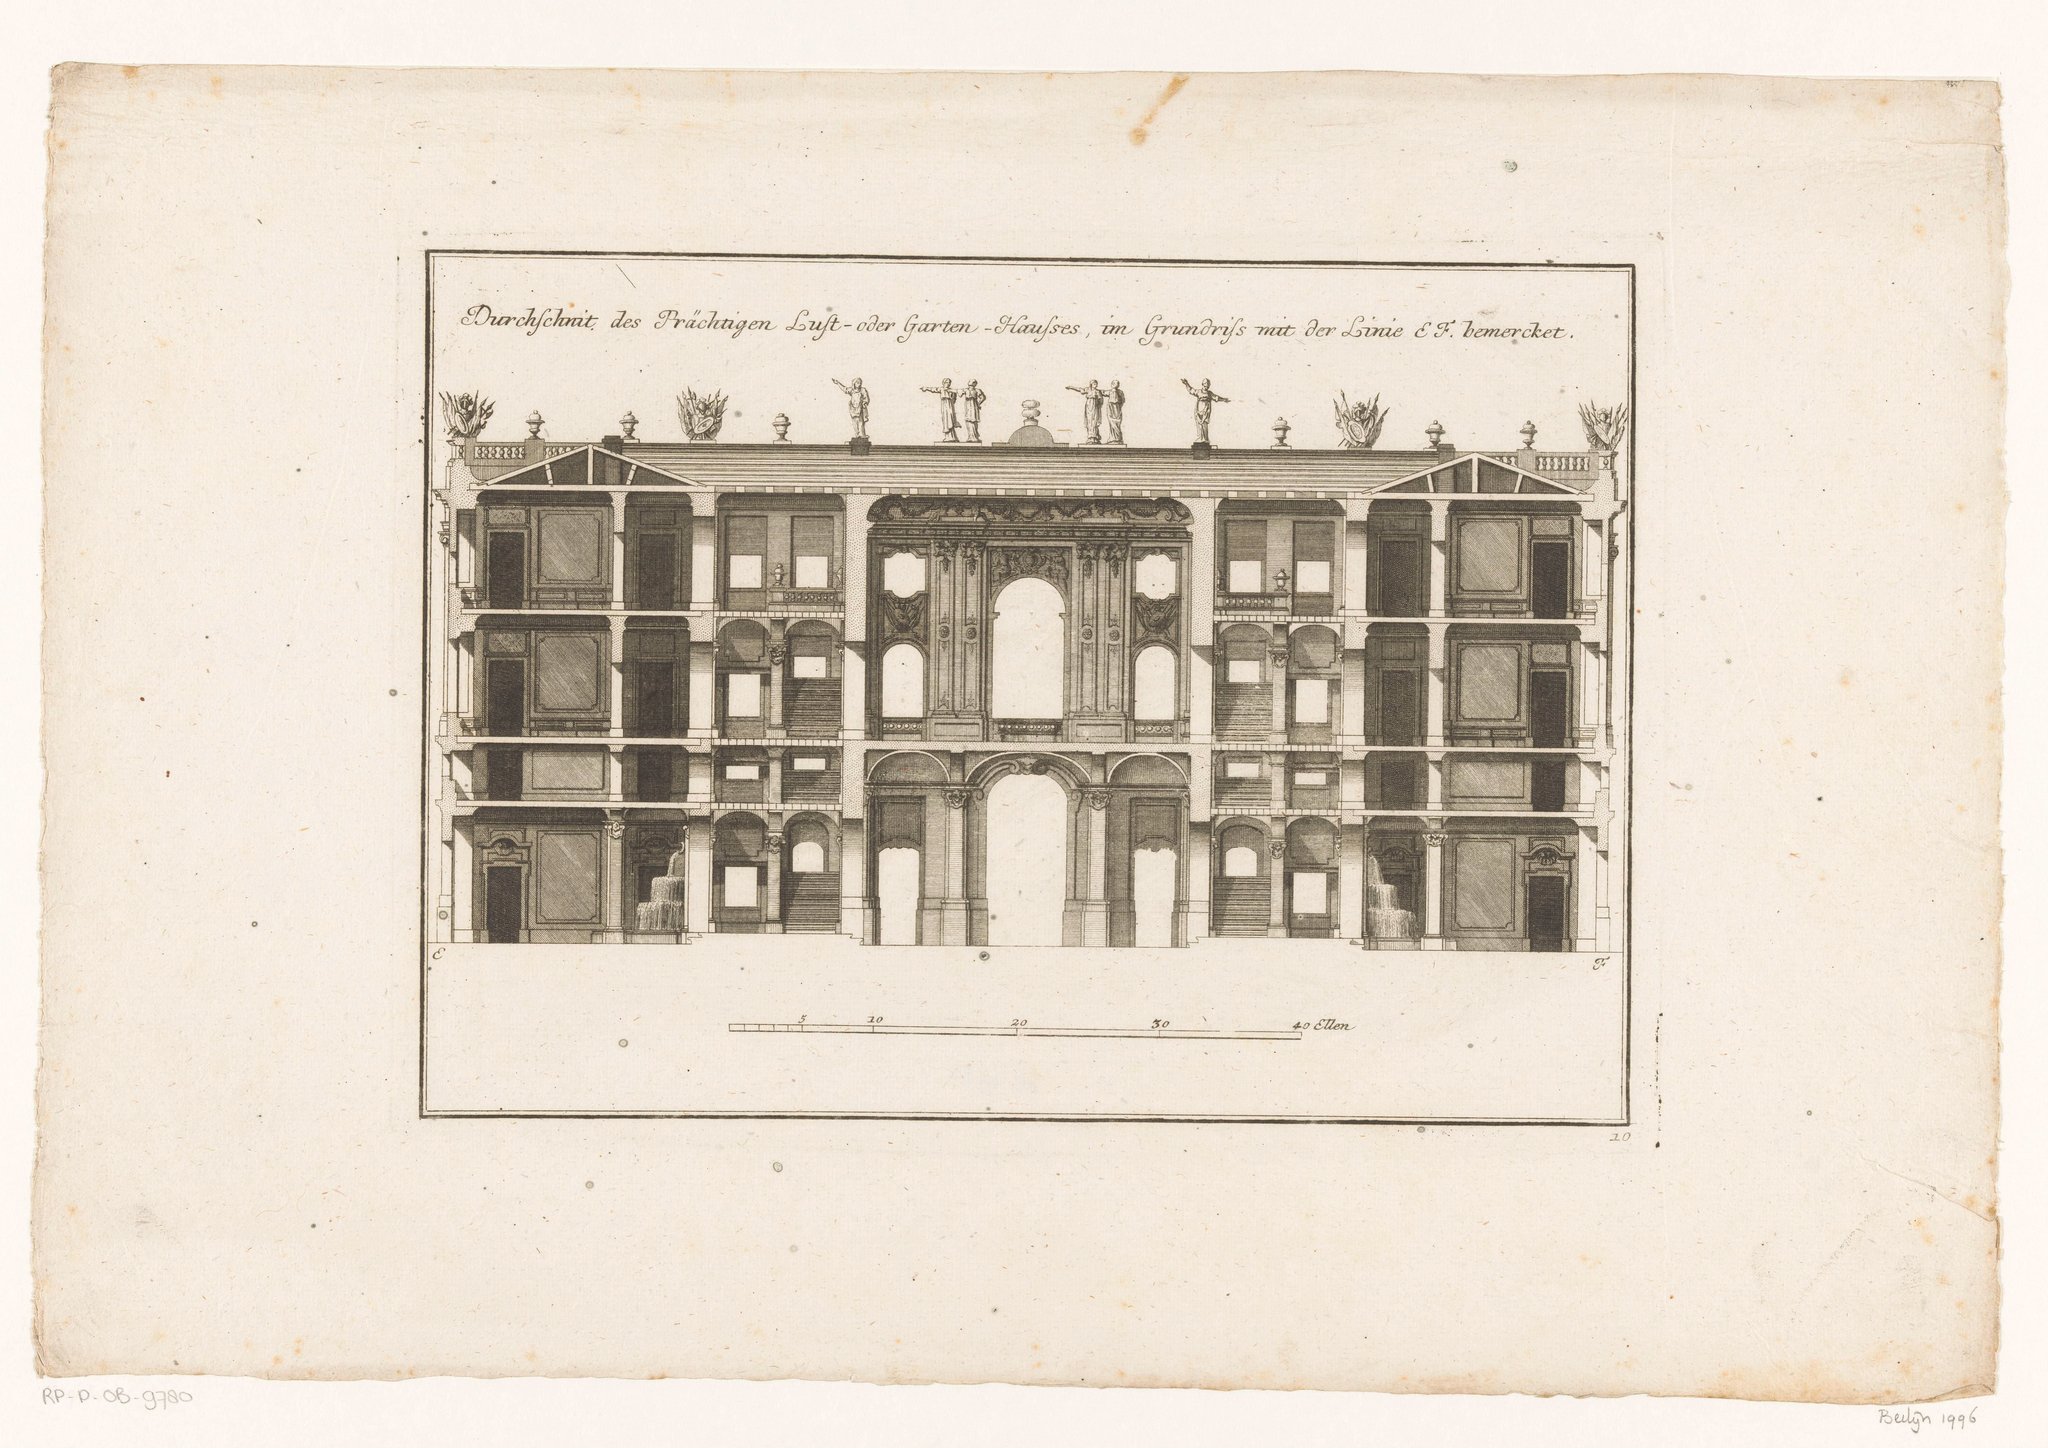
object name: print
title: Durchschnitt des Prächtigen Lust- oder Garten- Hausses, im Grundriss mit der Linie E F. bemercket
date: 1729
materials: paper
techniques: engraving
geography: nuremberg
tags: summer-house, arbour, garden-house (dutch: 'theekoepel'), section ~ architectural design or model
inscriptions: collector's mark: Lugt 2228